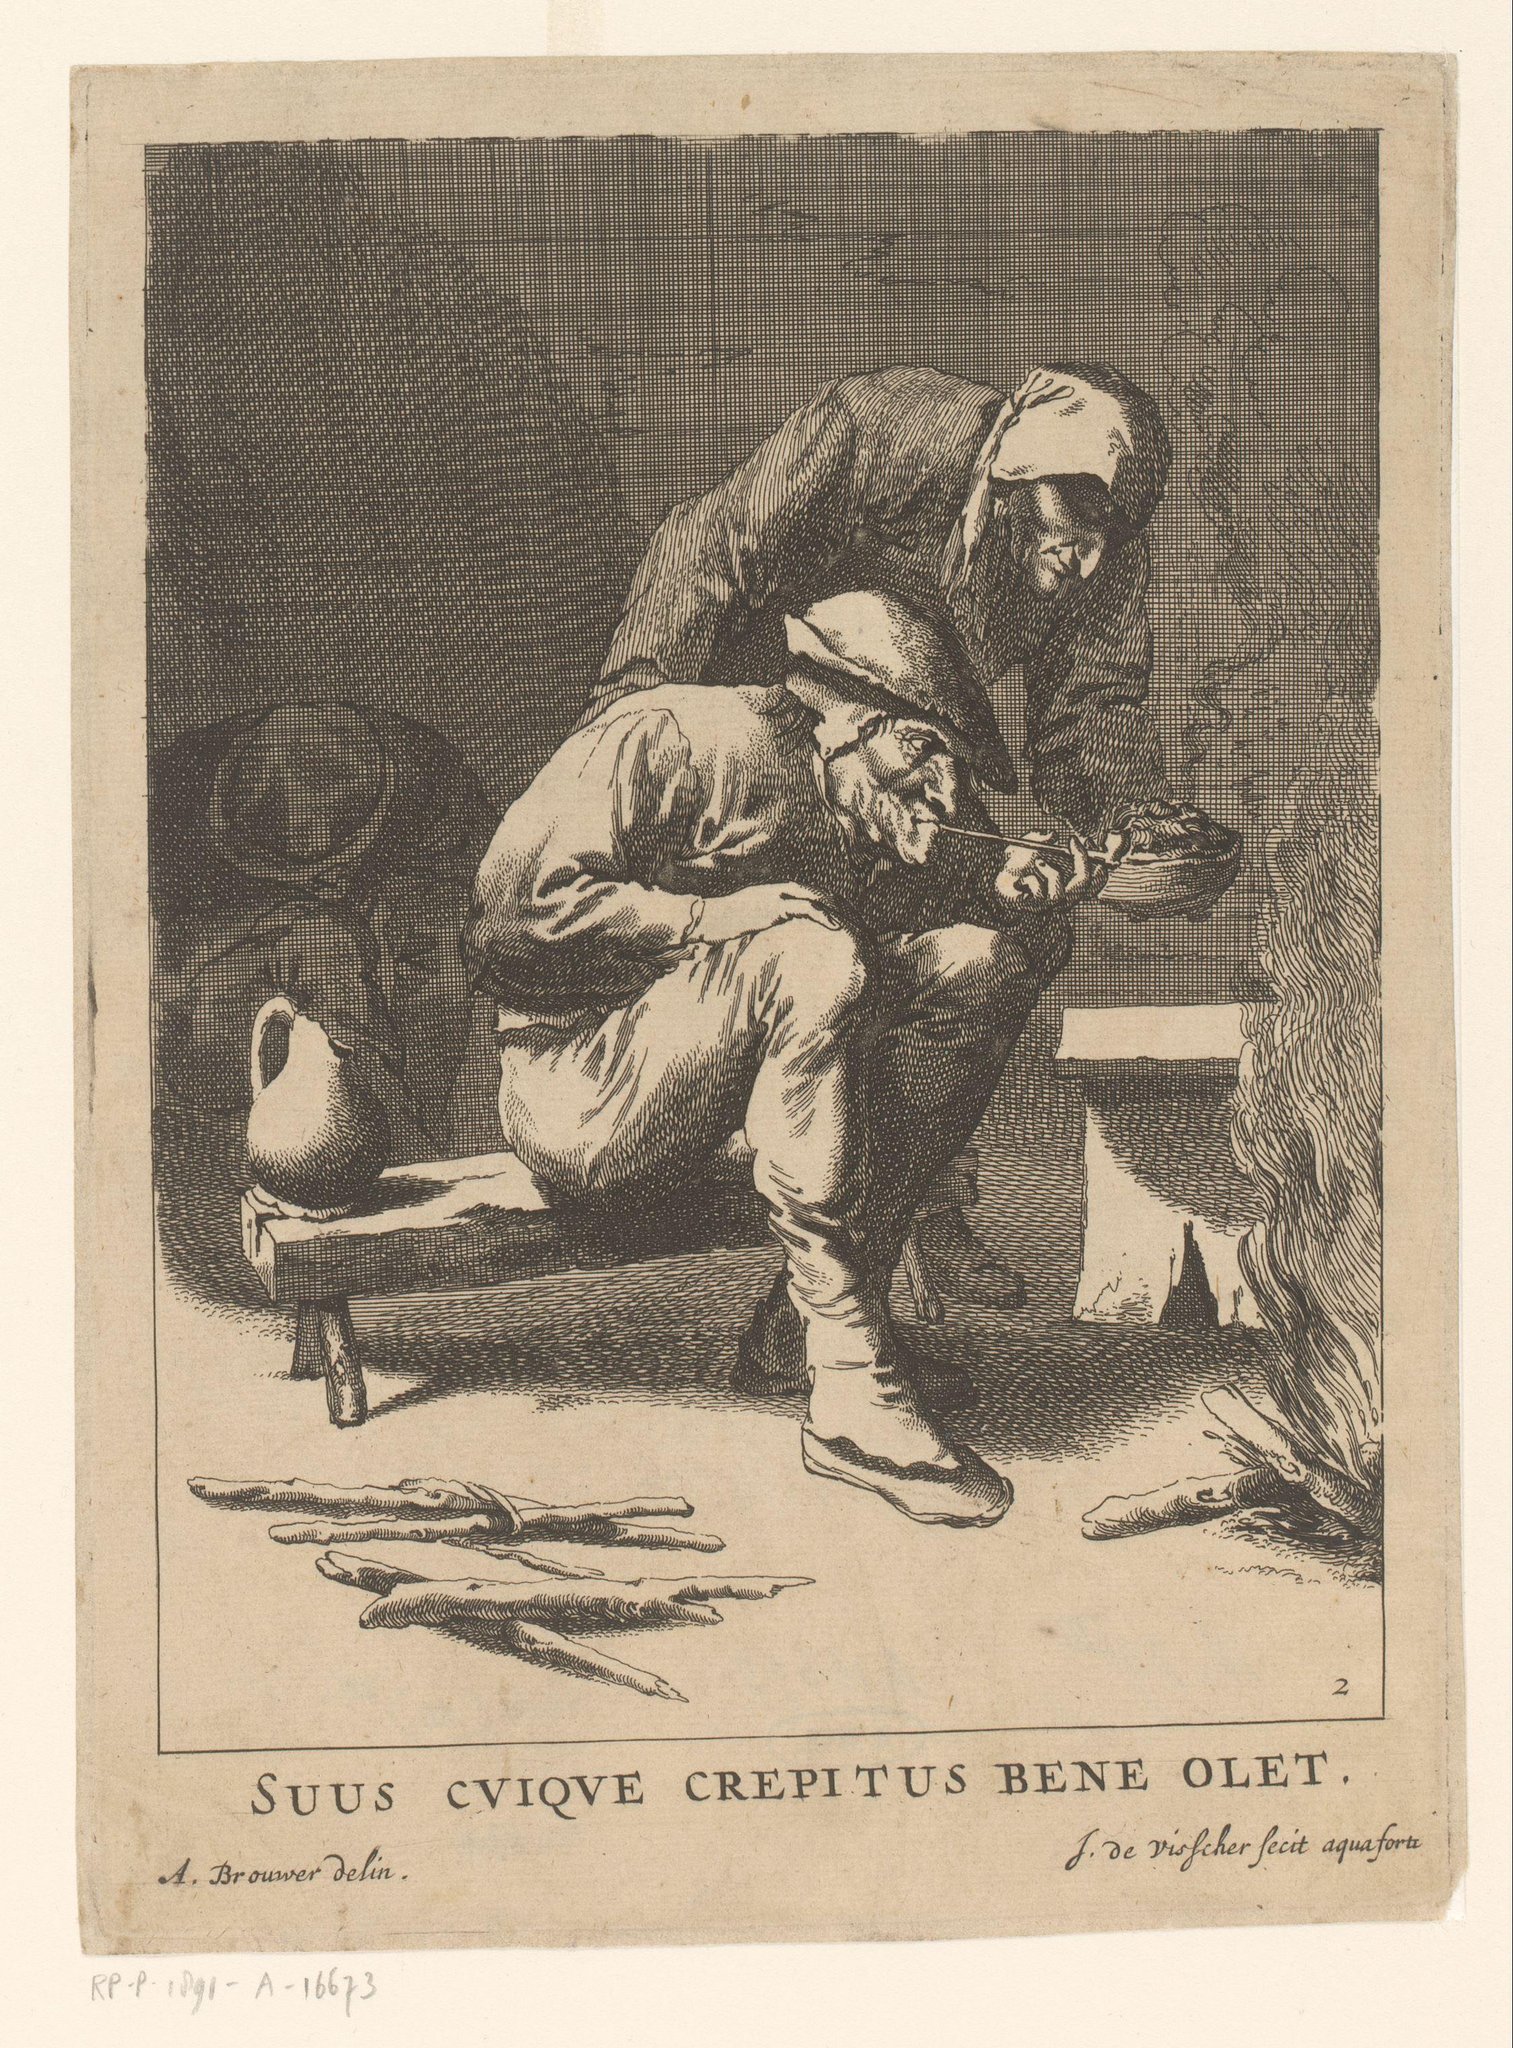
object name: print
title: Eenvoudige interieurs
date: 1643-1677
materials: paper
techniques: etching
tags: pipe ~ tobacco, open hearth, fire-place, farmers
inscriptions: collector's mark: Lugt 2228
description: Pijprokende man, zittend op een lage houten bank bij een haardvuur. Achter hem een oude vrouw die hem een vuurtest voorhoudt. Rechtsonder genummerd: 2.